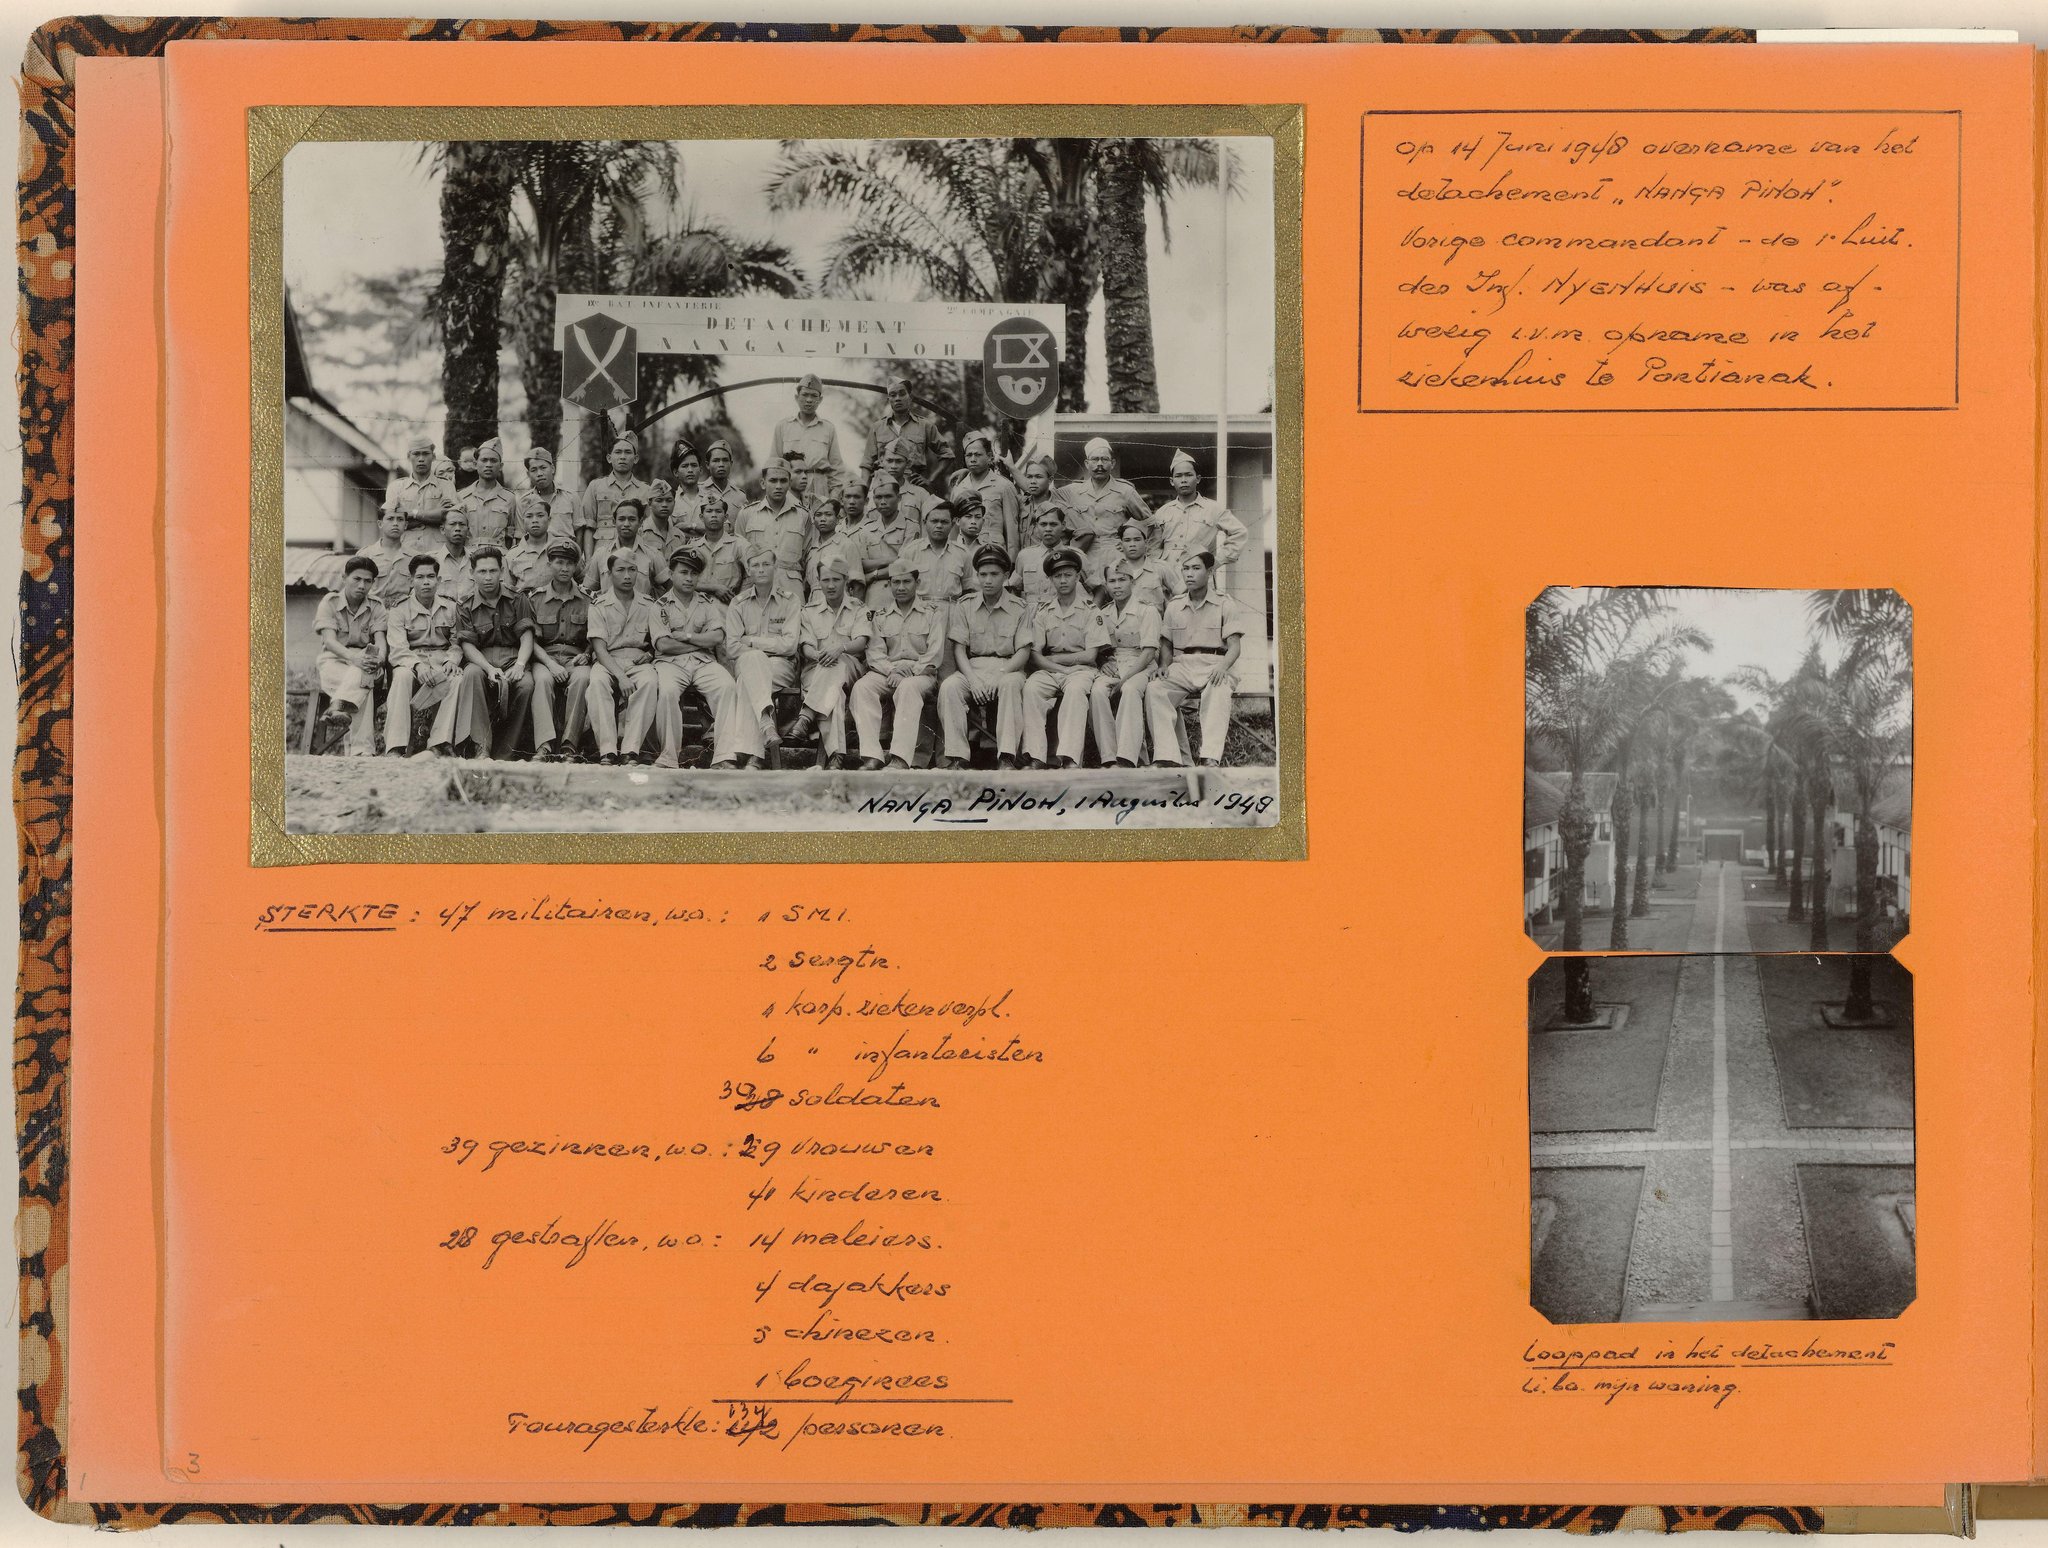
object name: album leaf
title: Detachement Nanga-Pinoh, 1948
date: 1948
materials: cardboard, photographic support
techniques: gelatin silver print, writing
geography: borneo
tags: theunissen (sergeant-majoor), borneo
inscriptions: inscription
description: Albumblad met 3 foto's van het Detachement Nanga-Pinoh, 1 augustus 1948. Groepsfoto van het detachement waarvan Theunissen commandant was en 2 foto's van het pad en woning van Theunissen in het detachemant. Onderdeel van het fotoalbum van de diensttijd van sergeant-majoor Theunissen in Borneo, 1947-1954.